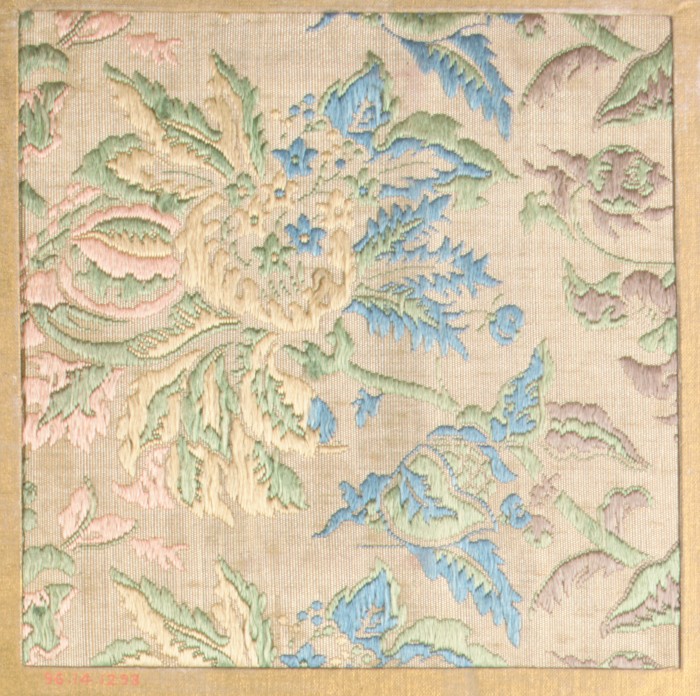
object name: piece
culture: japanese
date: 1701-1900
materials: silk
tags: flowers